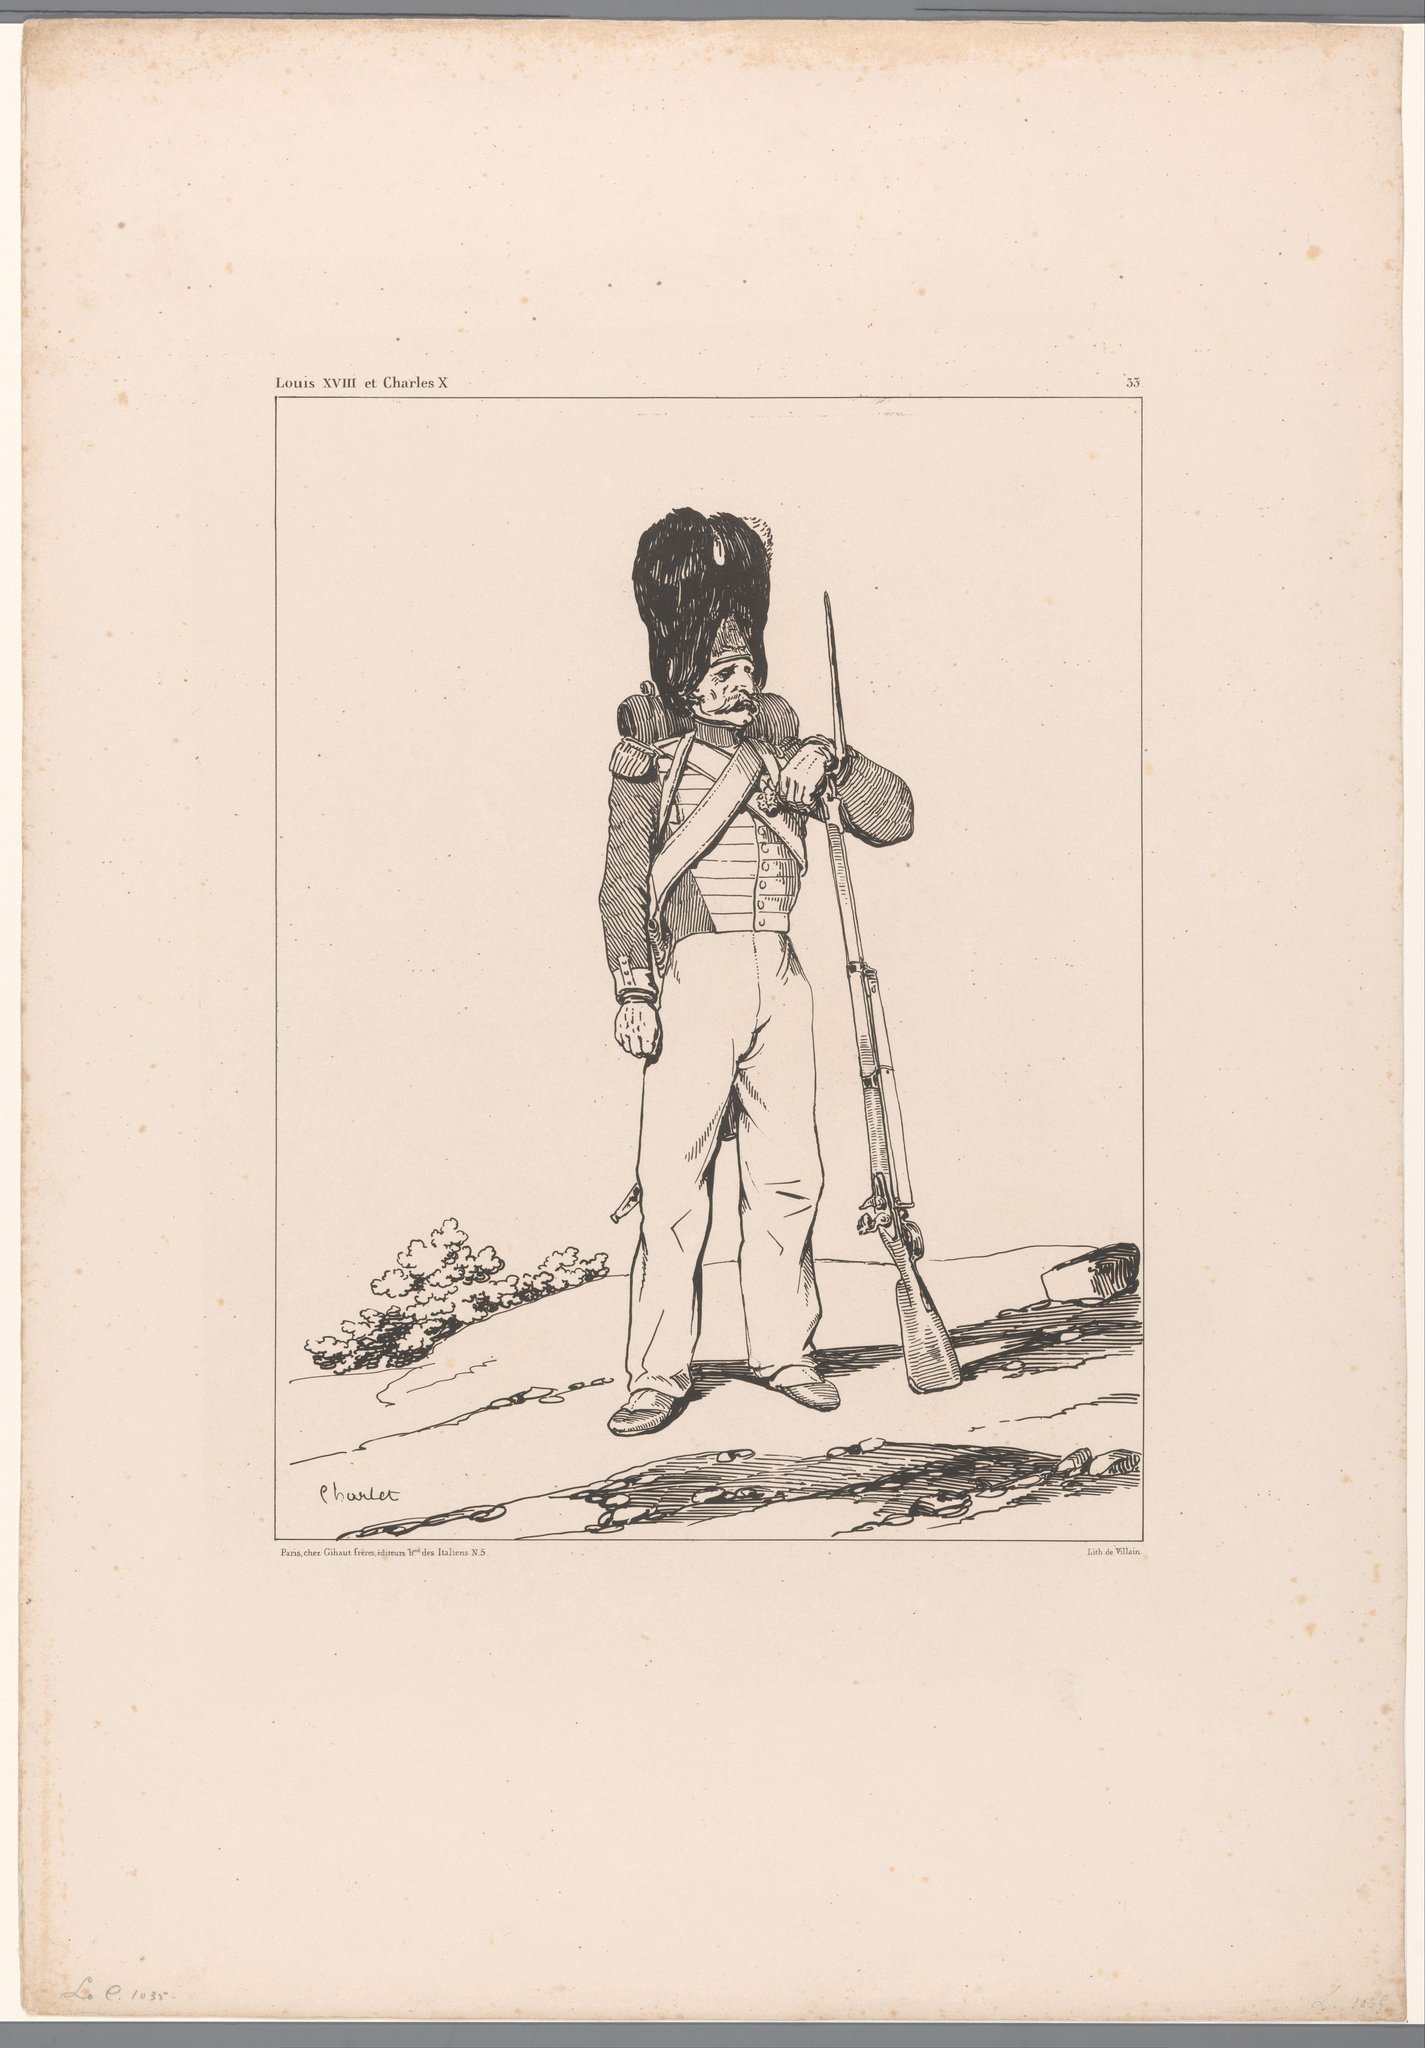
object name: print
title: Penlithografieën voor educatie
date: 1839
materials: paper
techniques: pen lithography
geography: paris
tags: private soldier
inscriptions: collector's mark: Lugt 2228a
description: Het kostuum van de grenadier werd gedragen tijdens het bewind van Lodewijk XVIII en Karel X van Frankrijk, door leden van de instituten 'La Maison militaire du Roi' en 'la Garde royale sous la Restauration française'.